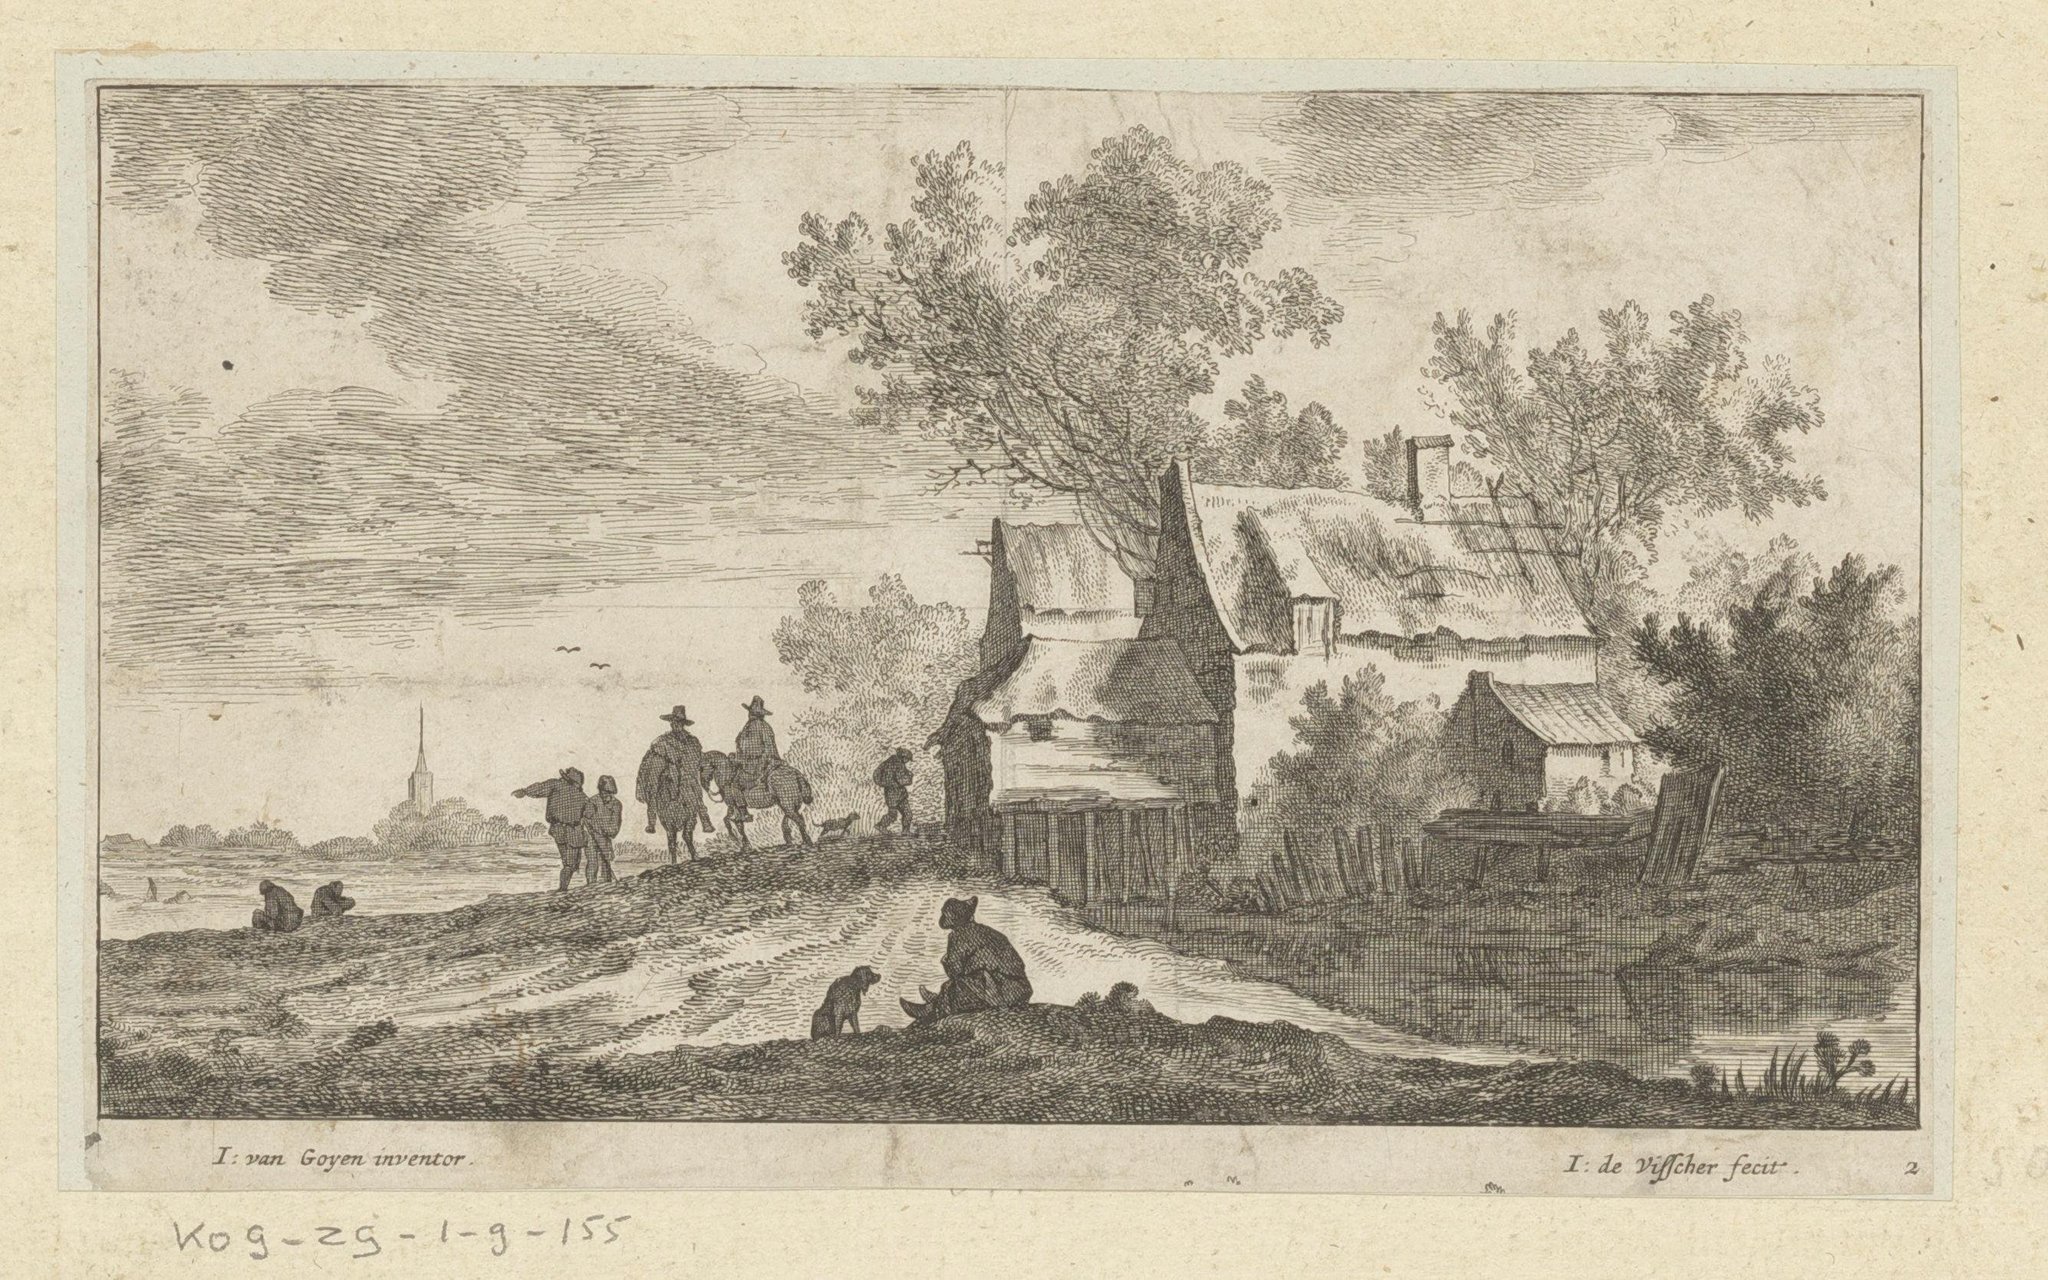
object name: print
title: Reizigers bij een huis aan het water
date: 1682-1709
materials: paper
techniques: engraving, etching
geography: amsterdam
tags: landscapes, church (exterior), 'en route', traveller under way, dog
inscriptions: collector's mark: Lugt 1641, stamp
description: Bij een huis aan het water bevinden zich enkele reizigers. Op de voorgrond zit een man met een hond en op de achtergrond zijn de contouren van een kerktoren te zien. Rechtsonder genummerd: 2. Onderwerpsrubrieken binnen de Atlas Zeden en Gewoonten: Handel, nijverheid en verkeer, Buitenleven.